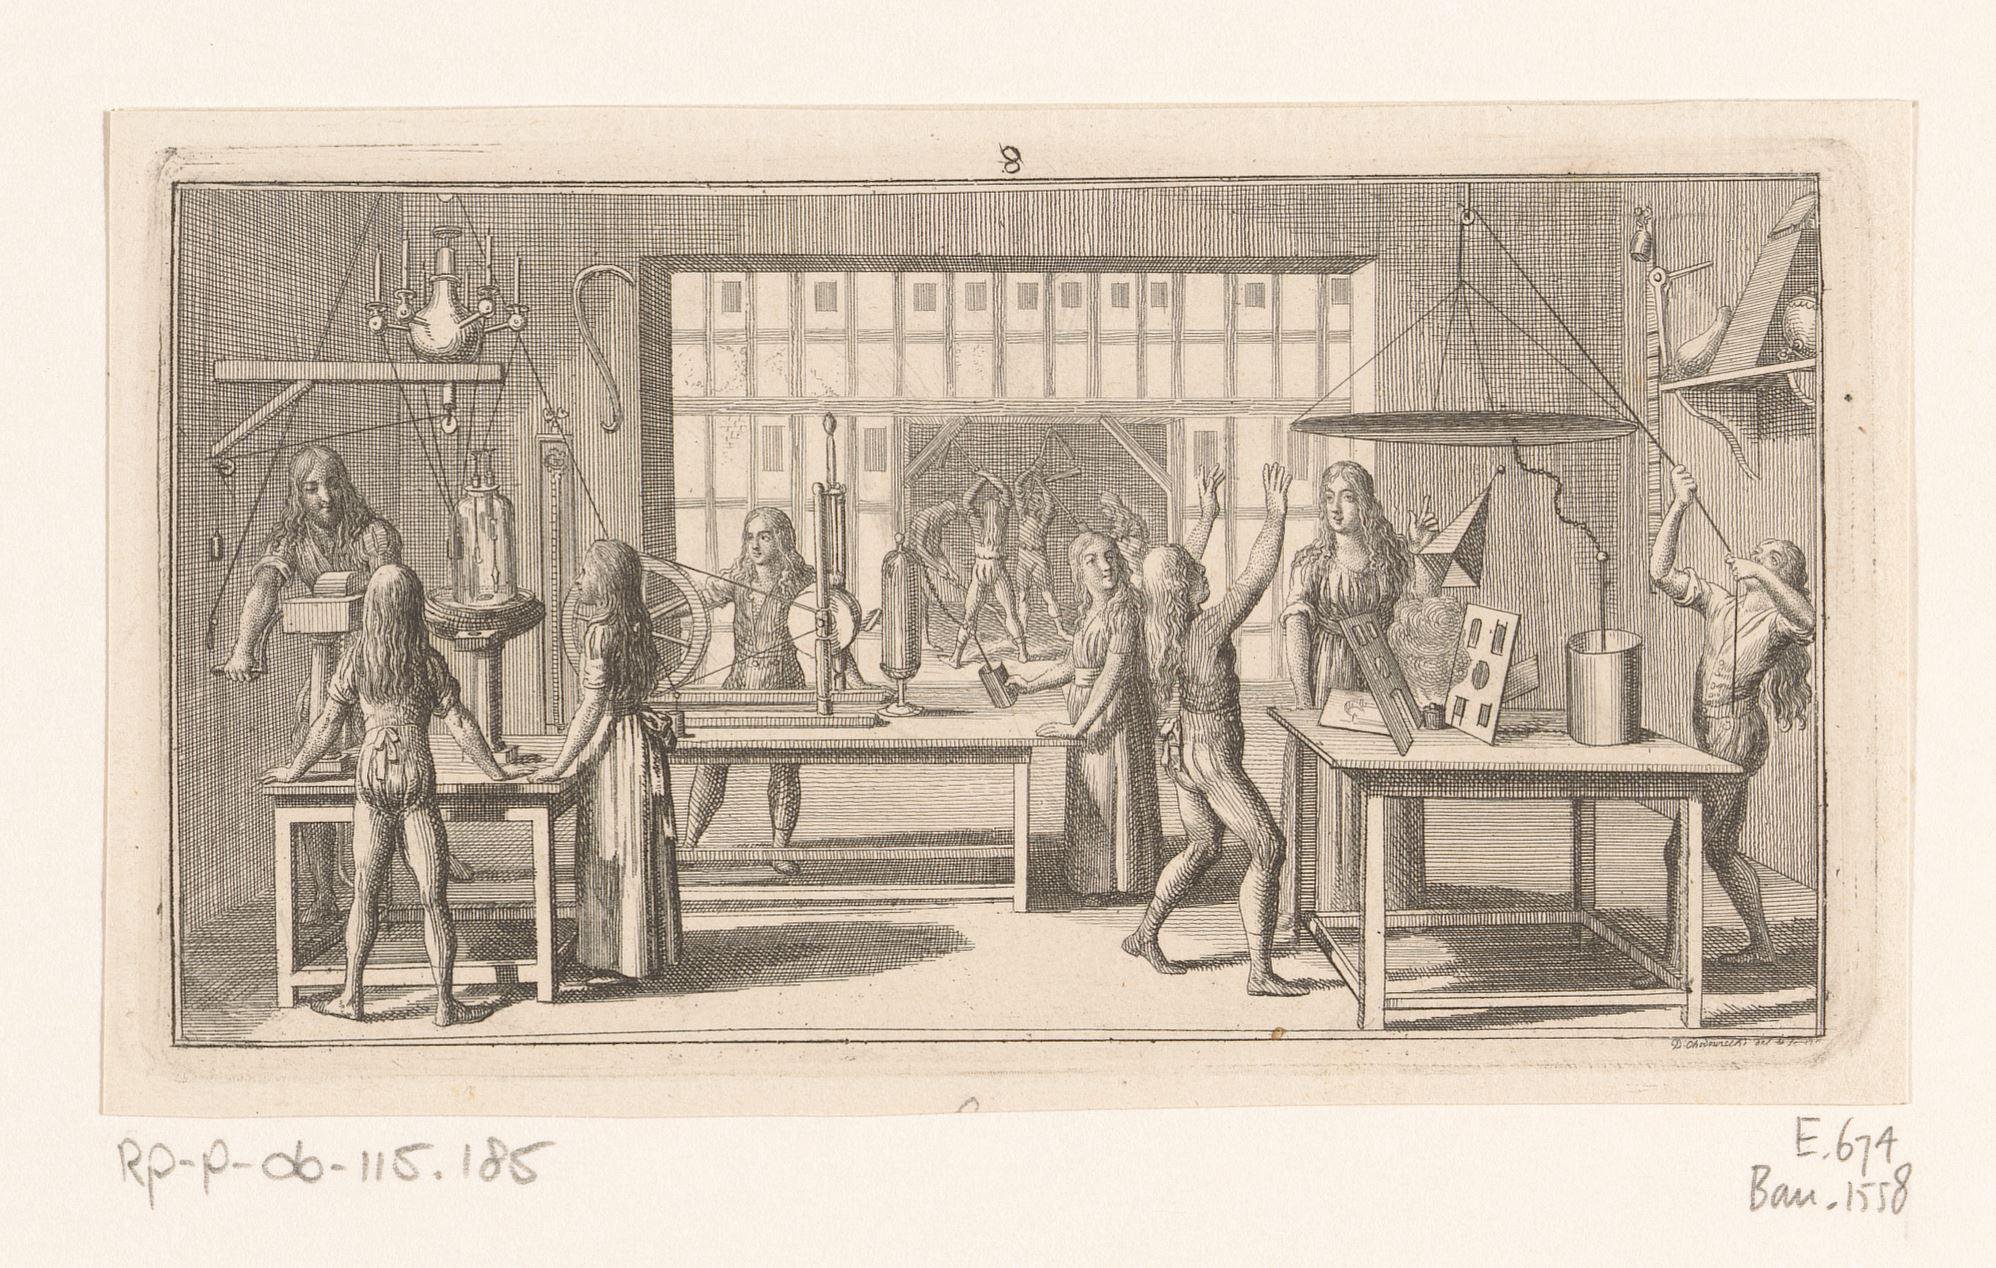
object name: print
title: Les in de werkplaats van een natuurkundige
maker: daniel nikolaus chodowiecki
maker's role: draughtsman, print maker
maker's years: 1726-1801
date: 1791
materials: paper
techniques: etching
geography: berlin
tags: physics, utopia, education, experiment, test ~ science and technology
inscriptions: collector's mark: Lugt 2228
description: Prent gebruikt voor: Ziegenhagen, Franz Heirnich. Lehre von dem richtigen Verhältnis zu den Schöpfungswerken, und durch öffentliche Einfürung derselben allein bewürkende algemeine Menschbeglükkung (...). Hamburg: s.n., 1792.